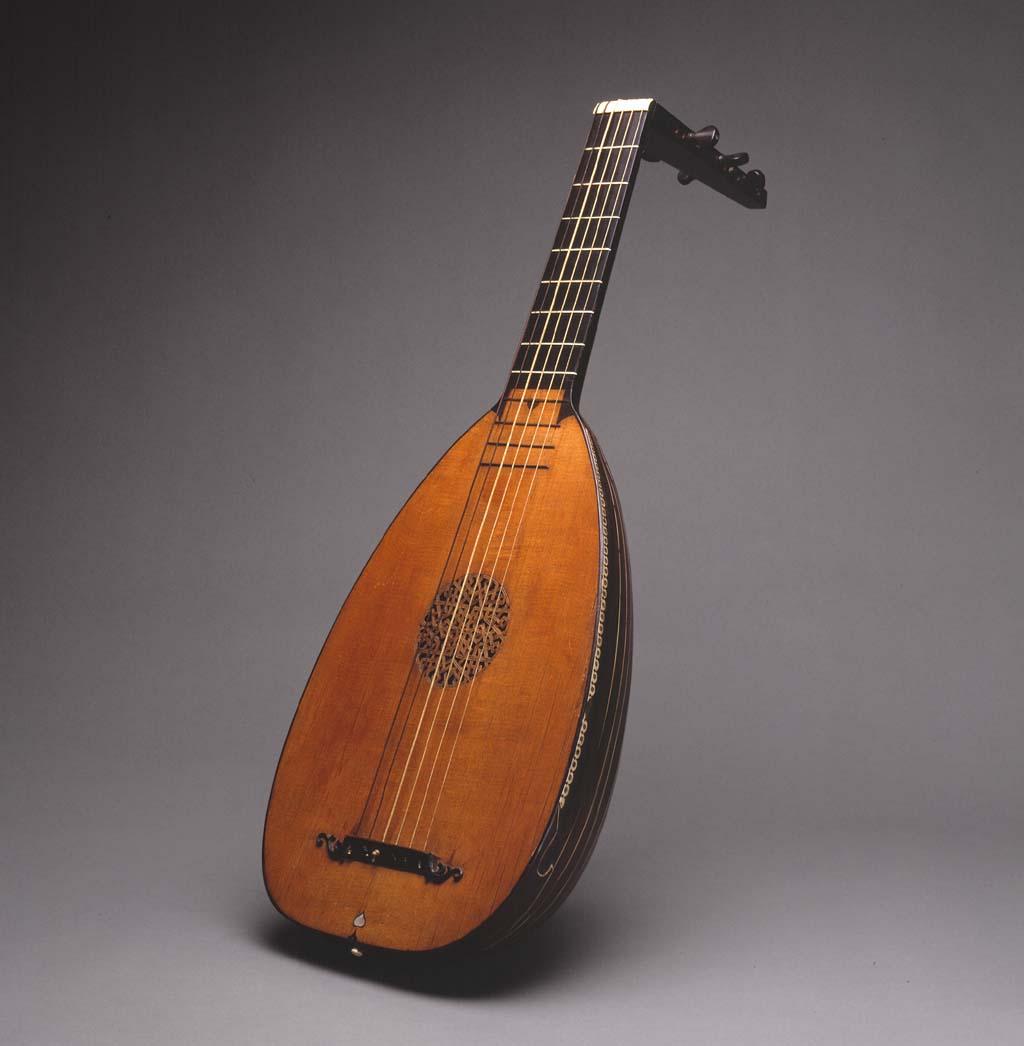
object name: lute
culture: german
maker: sixtus rauchwolff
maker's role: maker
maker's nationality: german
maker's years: 1556-1629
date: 1596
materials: wood, ivory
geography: germany